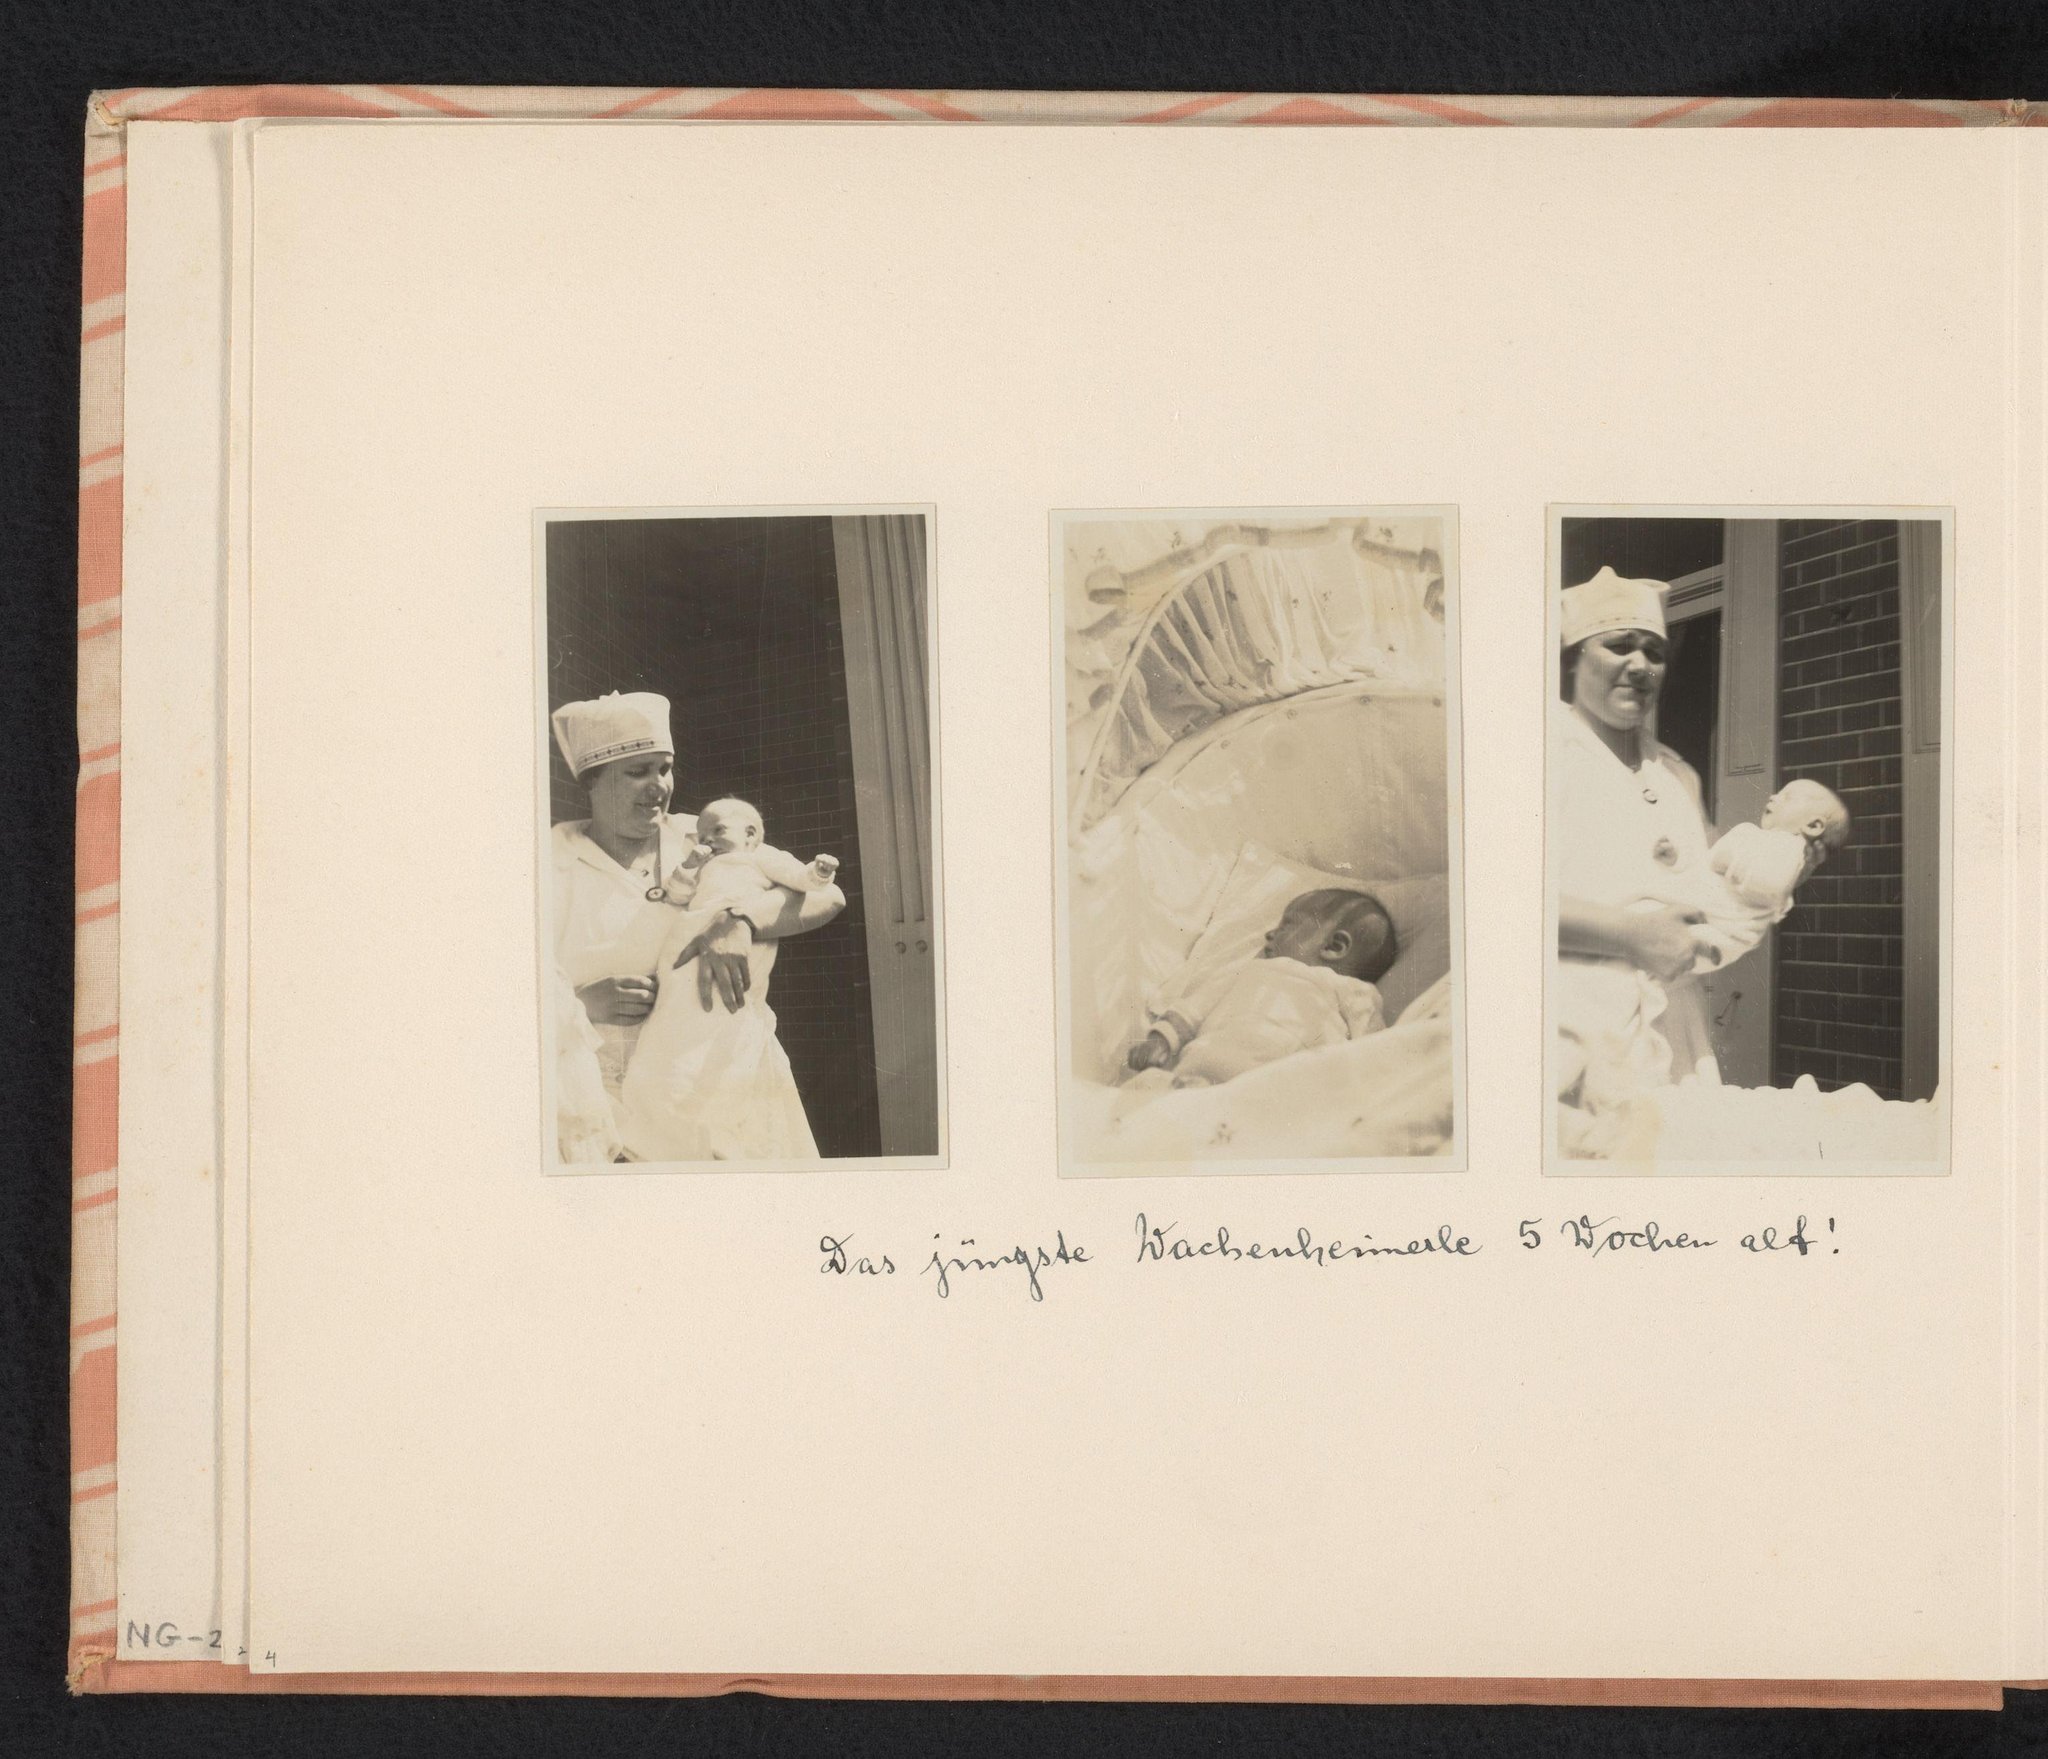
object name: photograph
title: Isabel Wachenheimer in de armen van een onbekende verpleegster, juni-juli 1928, Hamburg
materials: paper, photographic support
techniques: gelatin silver print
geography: hamburg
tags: else wachenheimer-moos, leiden, isabel wachenheimer-elon, family life at home, infant, baby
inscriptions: inscription: ‘Das jüngste Wachenheimer 5 Wochen alt!’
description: Albumblad met drie foto's. Foto links en rechts, Isabel Wachenheimer (rechts) en onbekende verpleegster (links); foto midden, Isabel Wachenheimer. Onderdeel van het fotoalbum met foto's van Isabel Wachenheimer als kind (1928-1931).